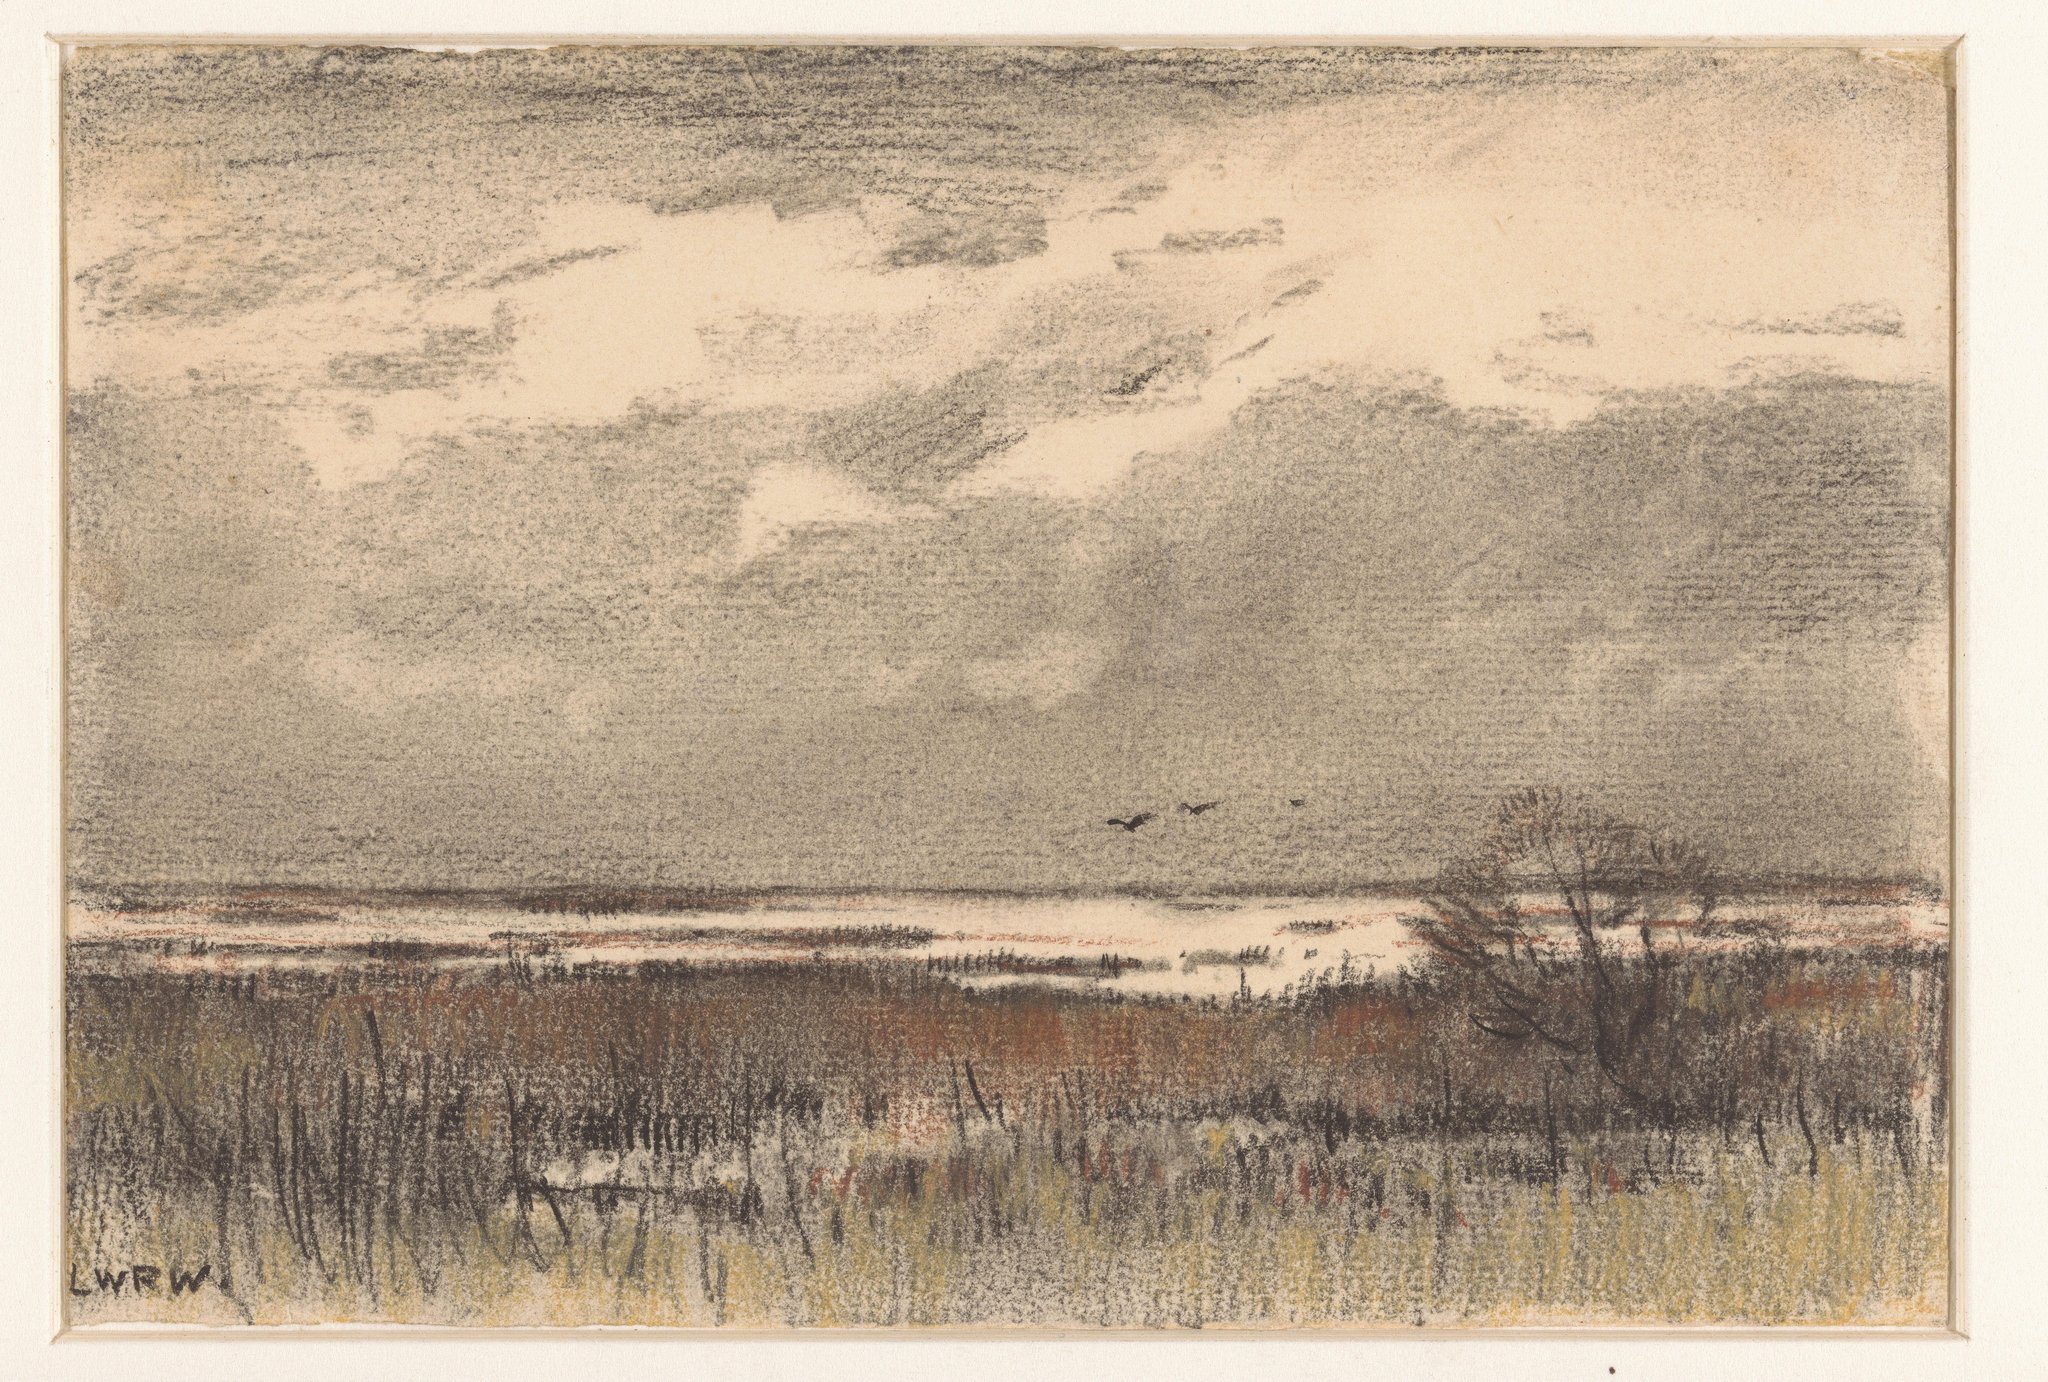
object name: drawing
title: Loosdrechtse plassen, met donkere wolkenlucht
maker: willem wenckebach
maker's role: designer, draughtsman, painter, print maker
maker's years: 1860-1937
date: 1870-1937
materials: chalk, paper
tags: lake